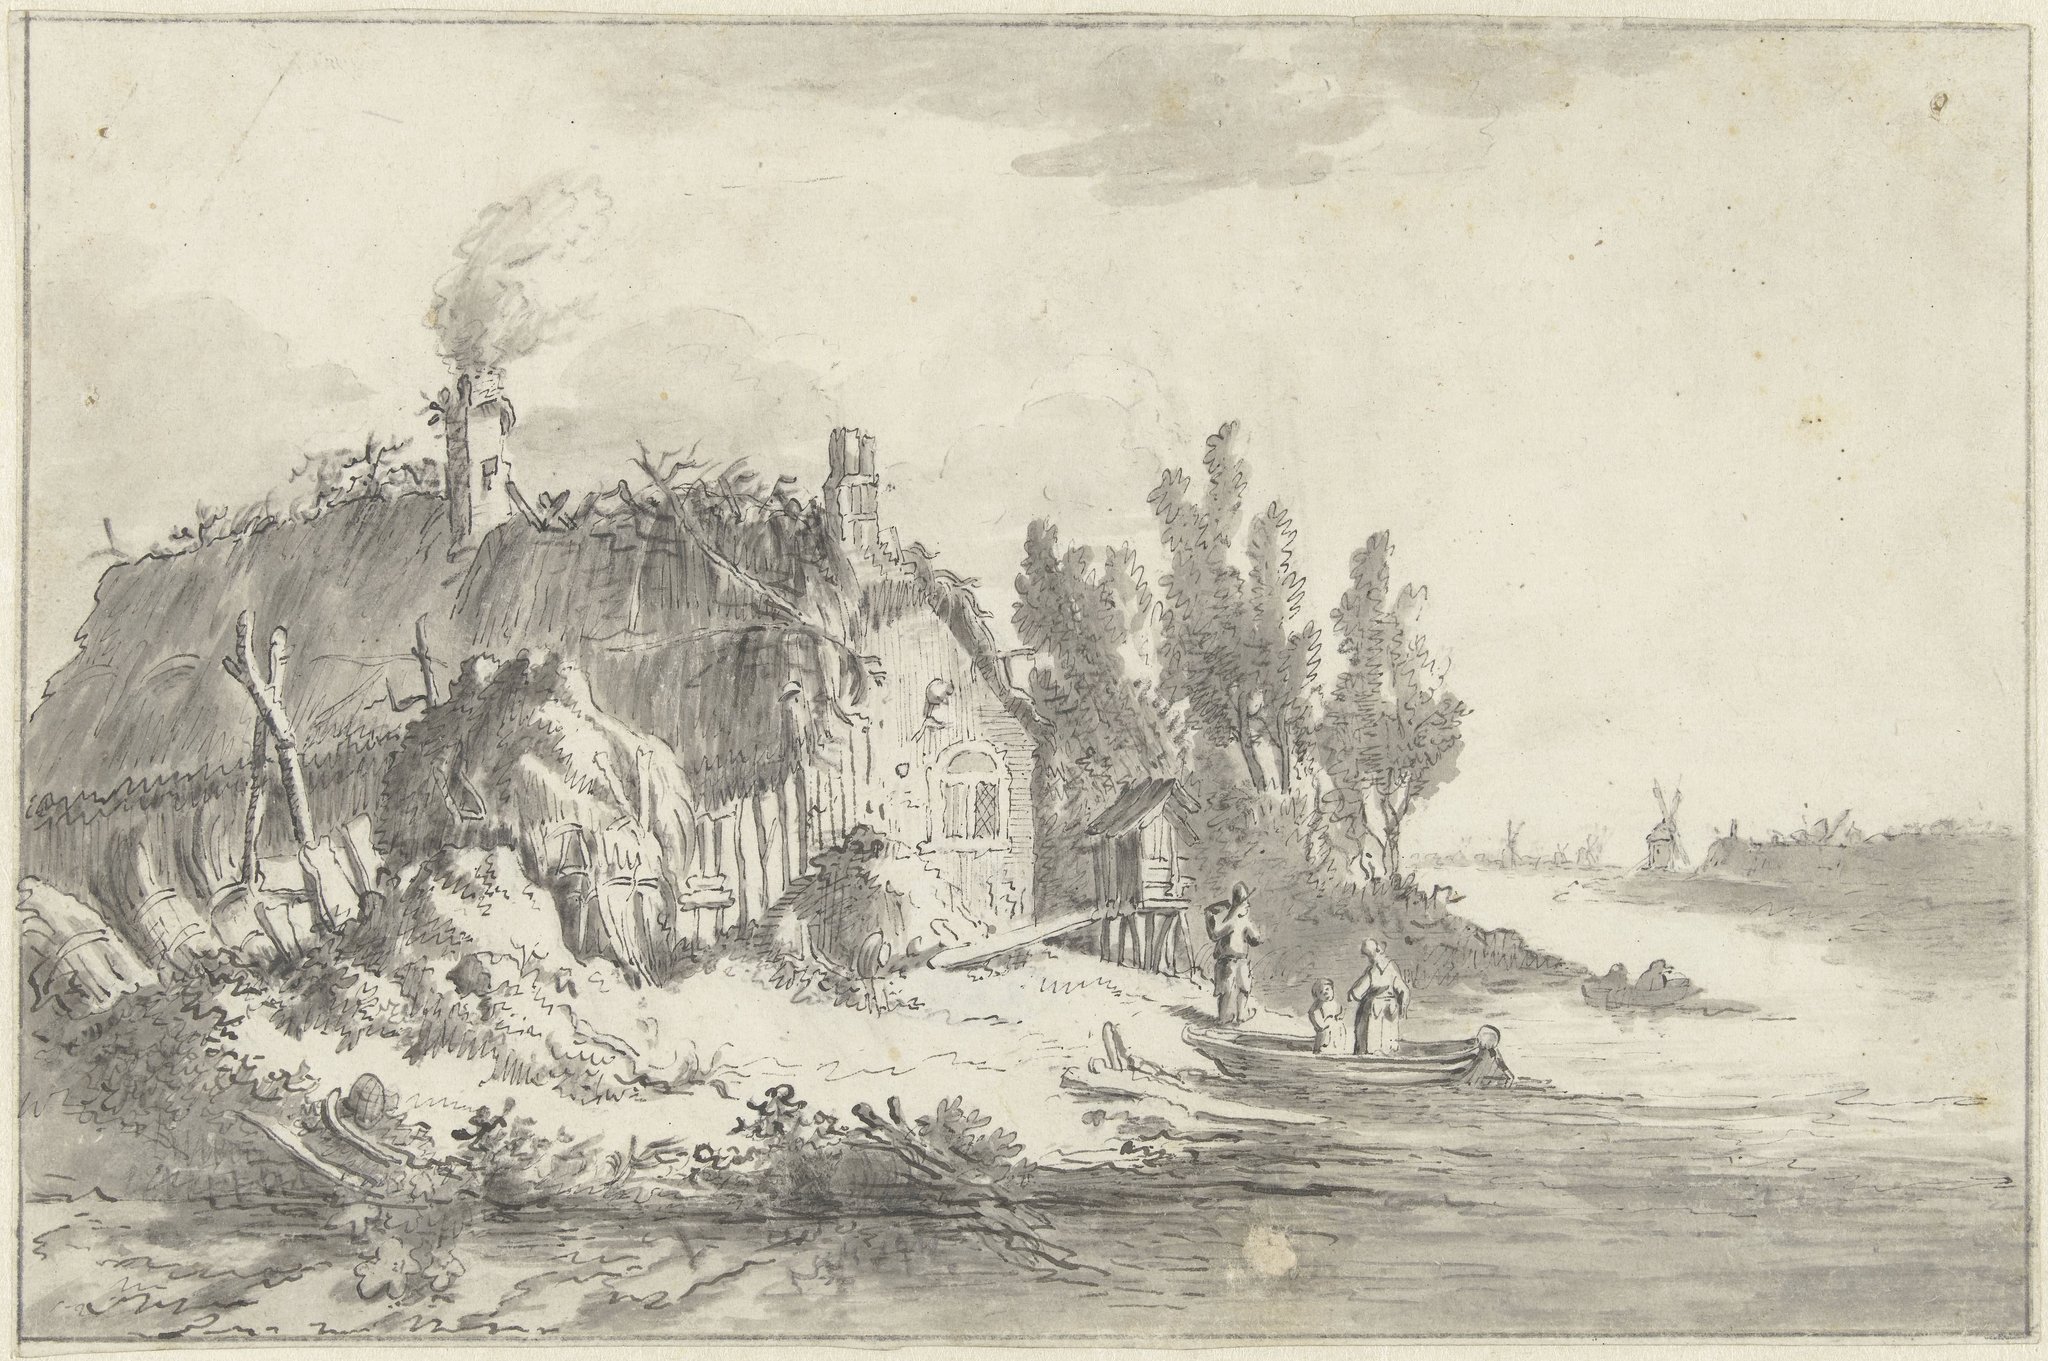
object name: drawing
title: Vervallen boerenhuis aan een rivier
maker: jacob ernst marcus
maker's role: draughtsman, print maker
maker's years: 1774-1826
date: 1789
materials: chalk, ink, paper, pencil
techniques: brush, pen